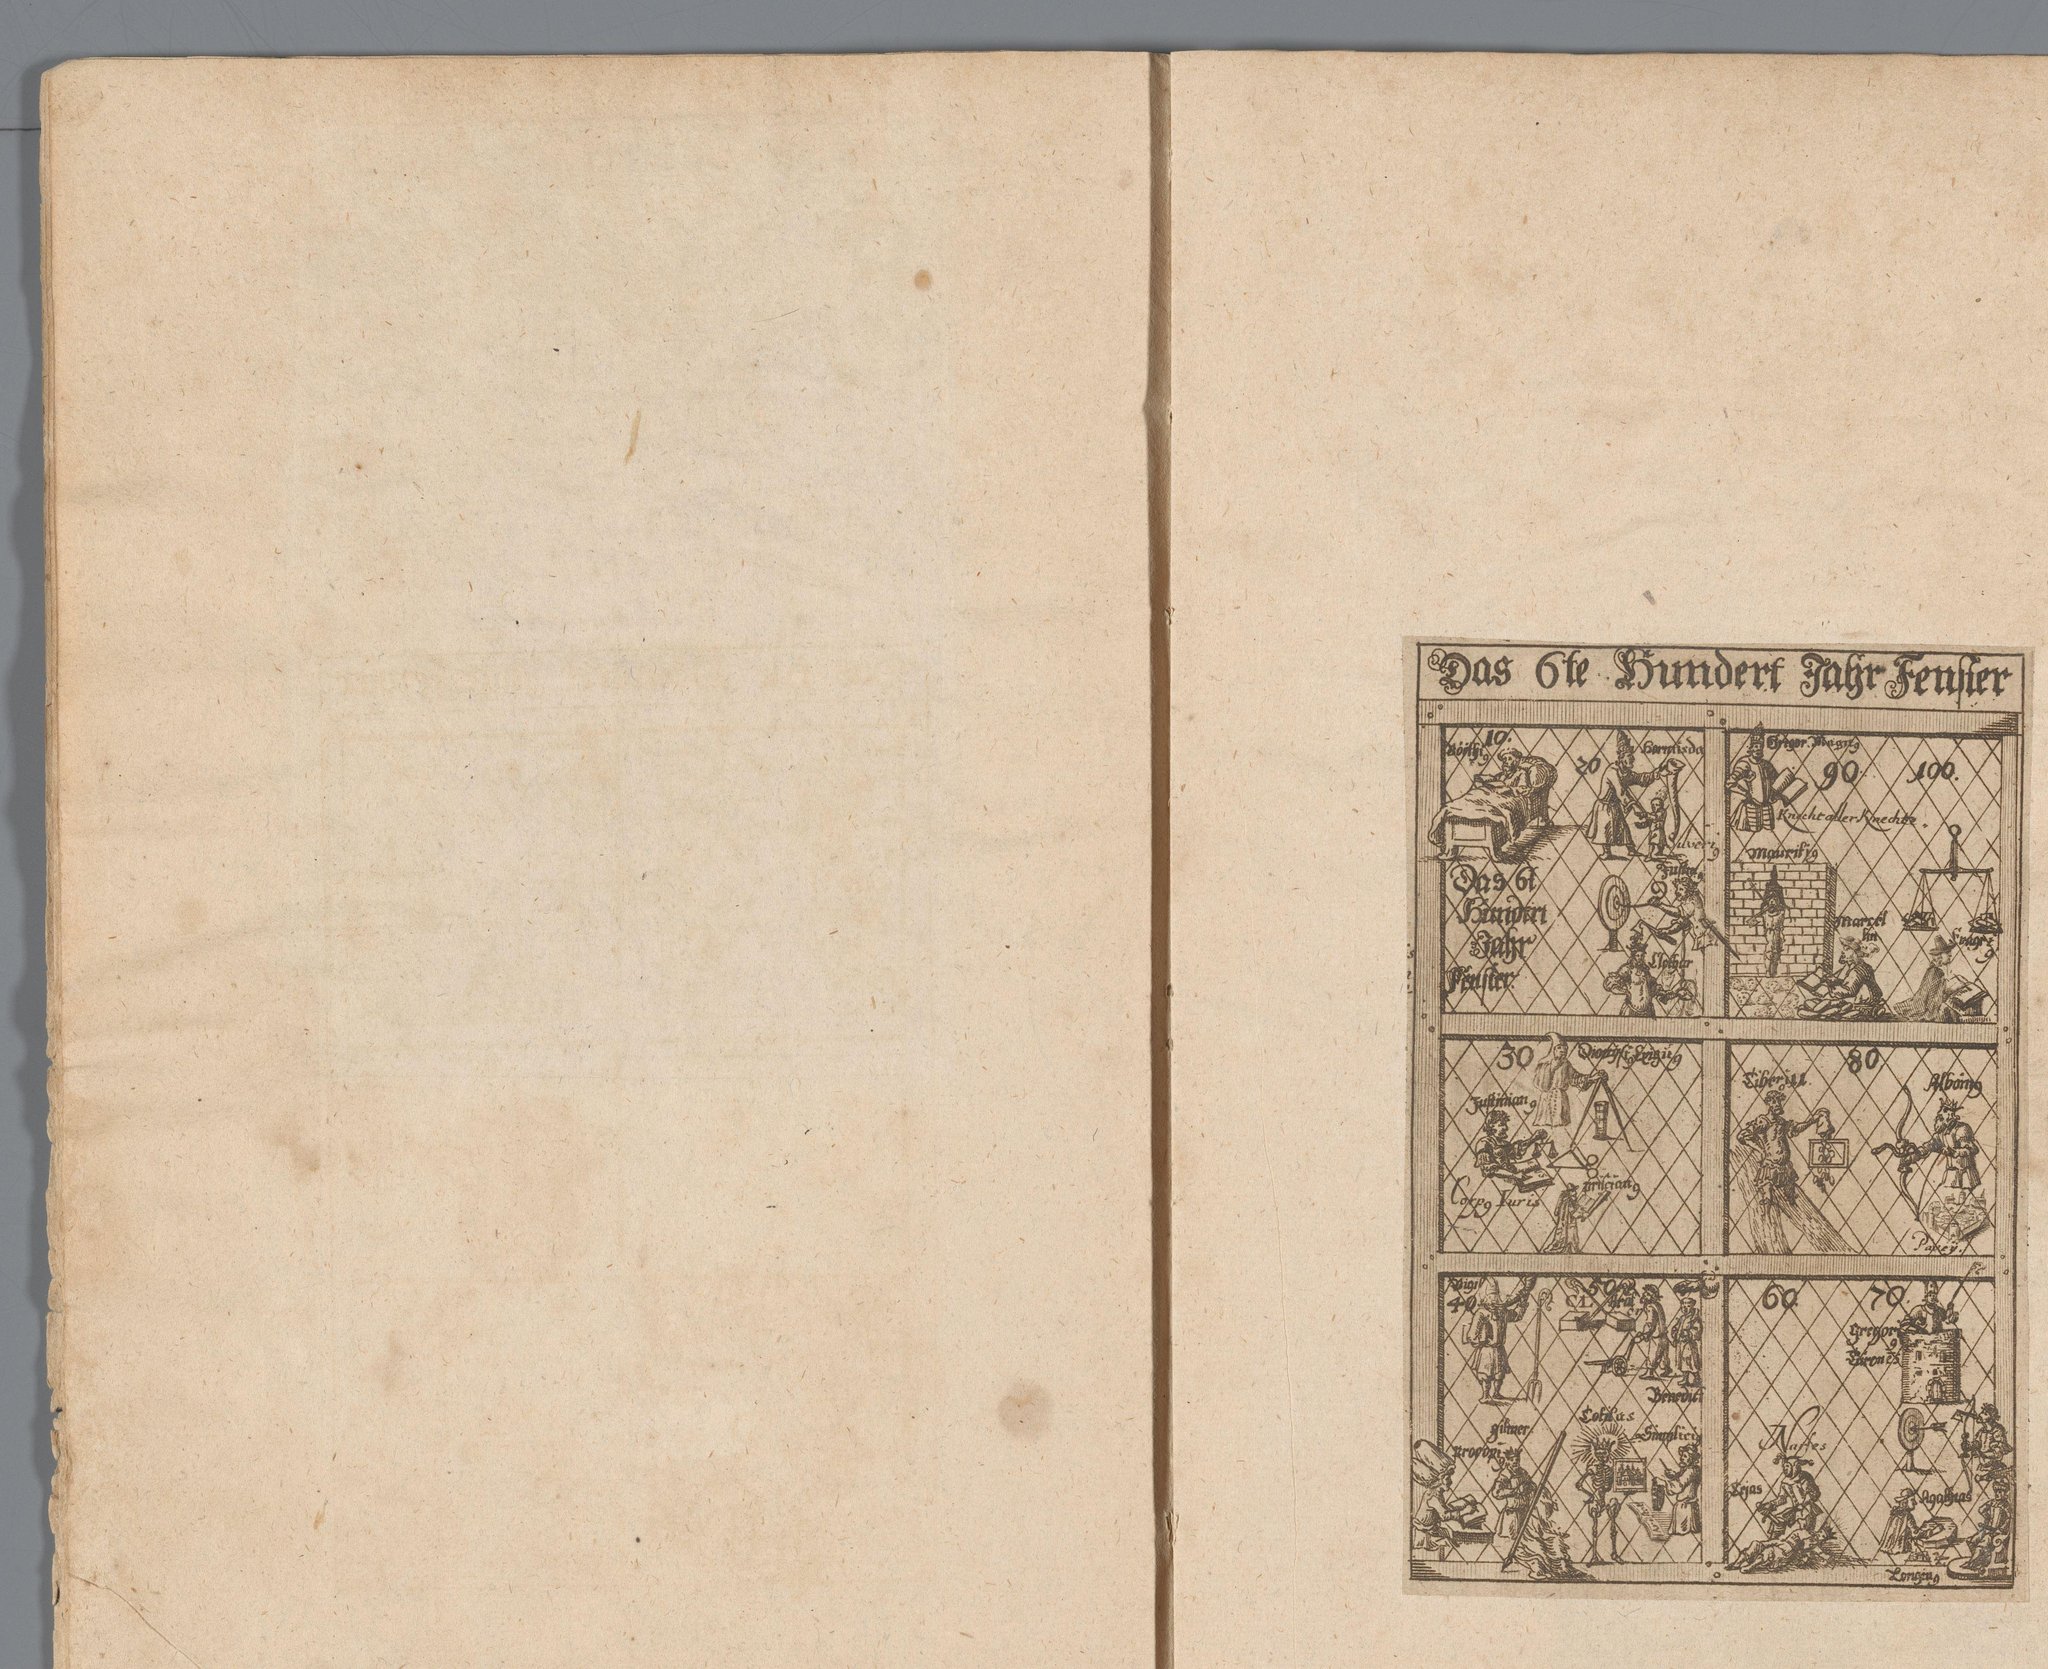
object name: print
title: Zevende eeuw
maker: Anonymous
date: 1667-1672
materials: paper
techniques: engraving, etching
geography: germany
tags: griffin (lion/eagle); 'griffo' (ripa)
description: Prenten afkomstig uit een editie van: Johannes Buno, Historische Bilder/ Darinnen Idea Historiae Universalis : Eine kurtze Summarische Abbildung Der fürnehmsten Geist- und Weltlichen Geschichte durch die vier Monarchien ..., eerst uitgegeven door Bartold Elers in Lüneburg in 1672.